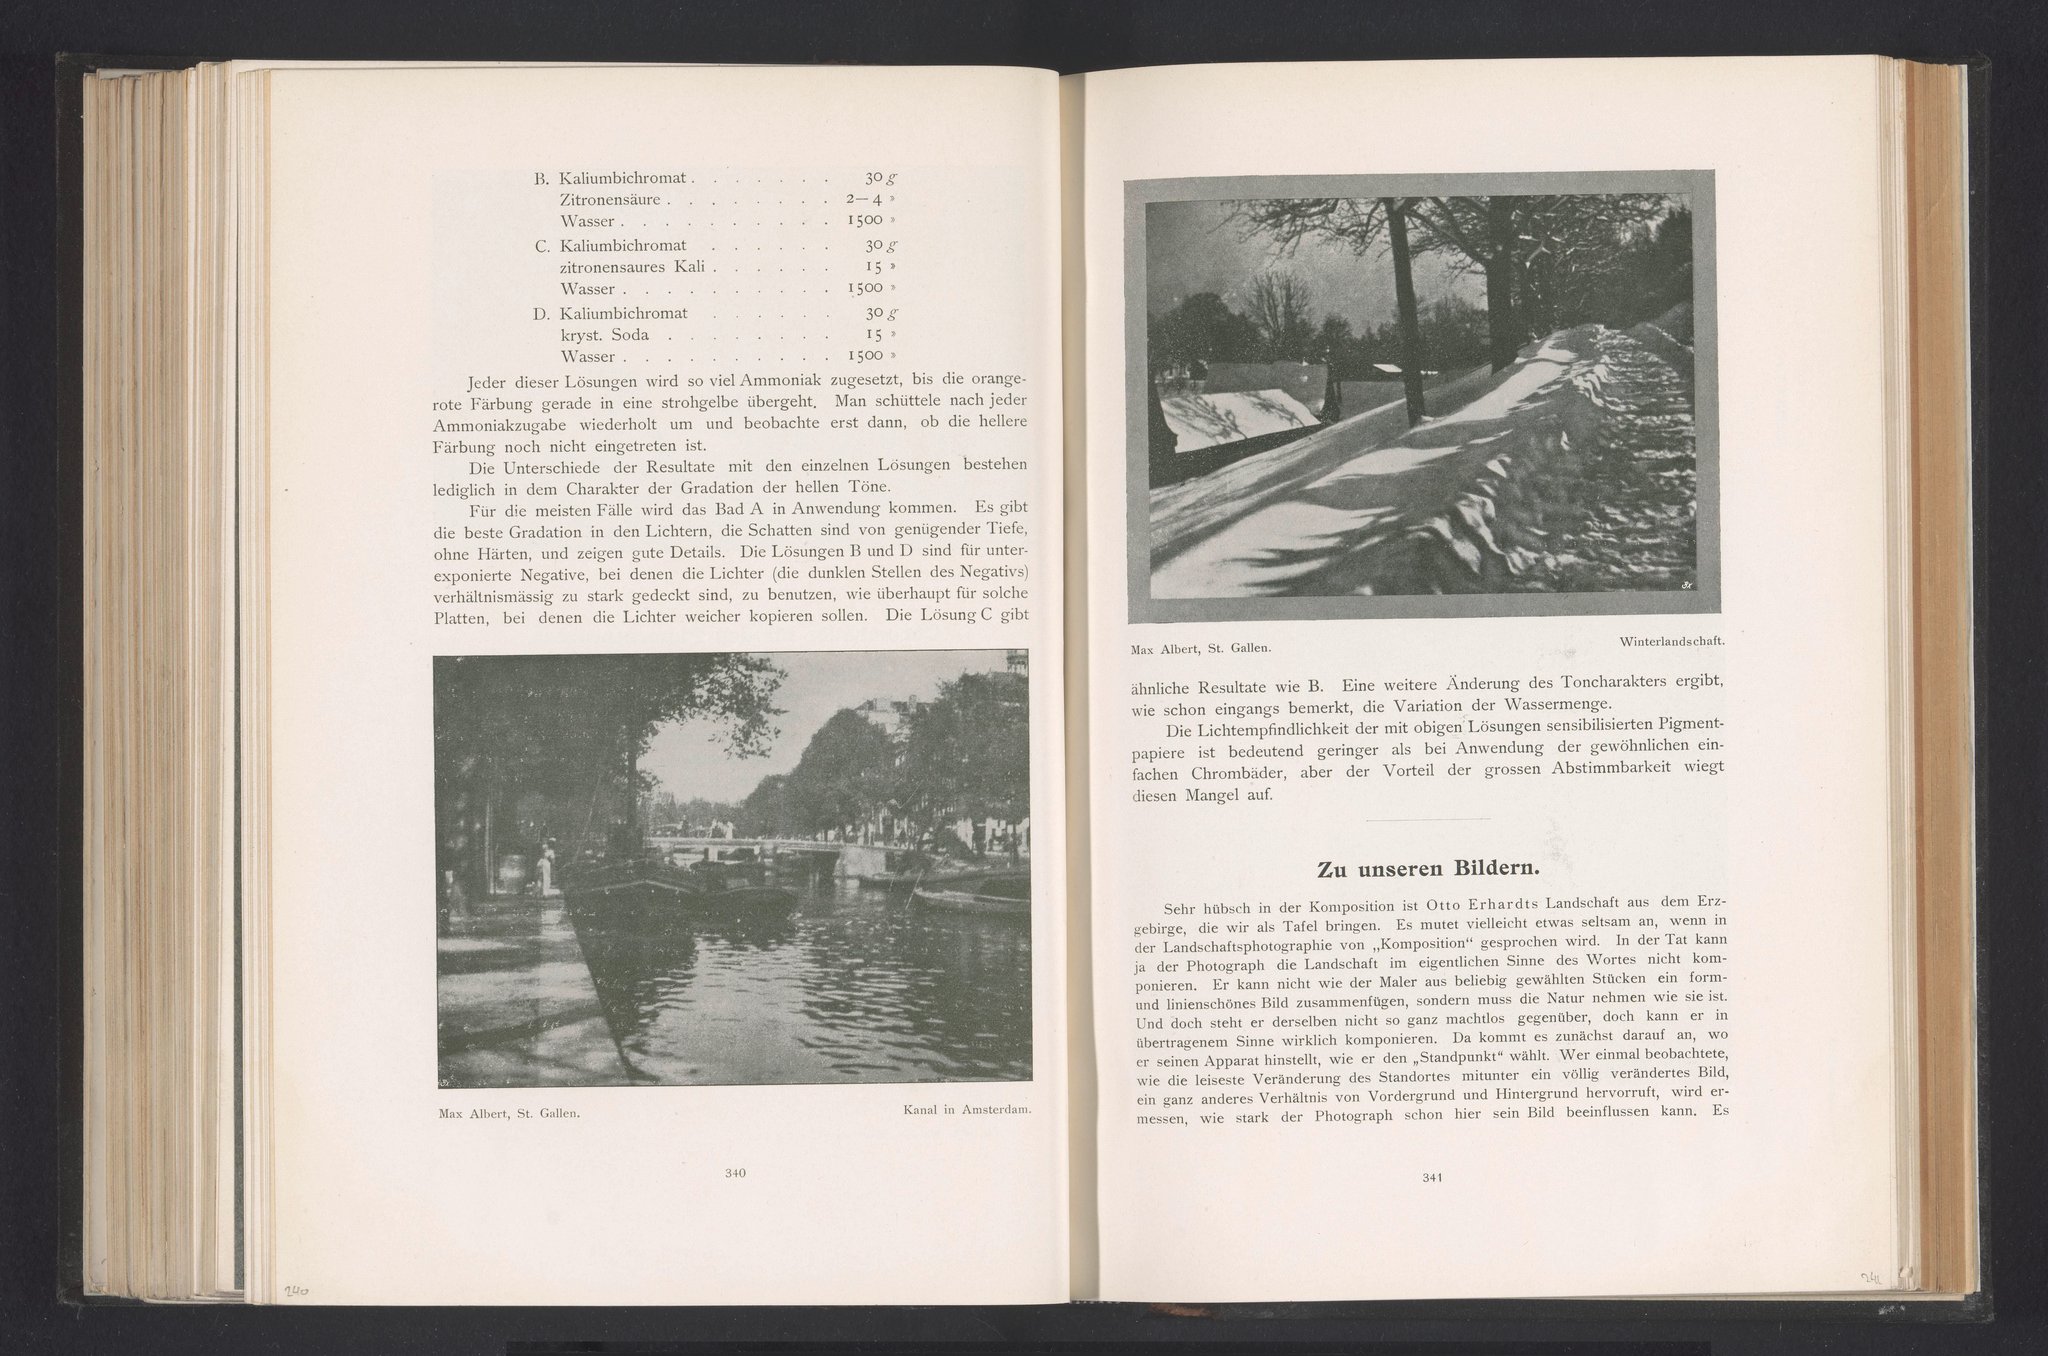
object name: page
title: Kanal in Amsterdam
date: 1898-1903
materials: paper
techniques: autotype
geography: amsterdam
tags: city-view in general; 'veduta', canals, waters (in city), amsterdam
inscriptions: monogram: ‘BX’